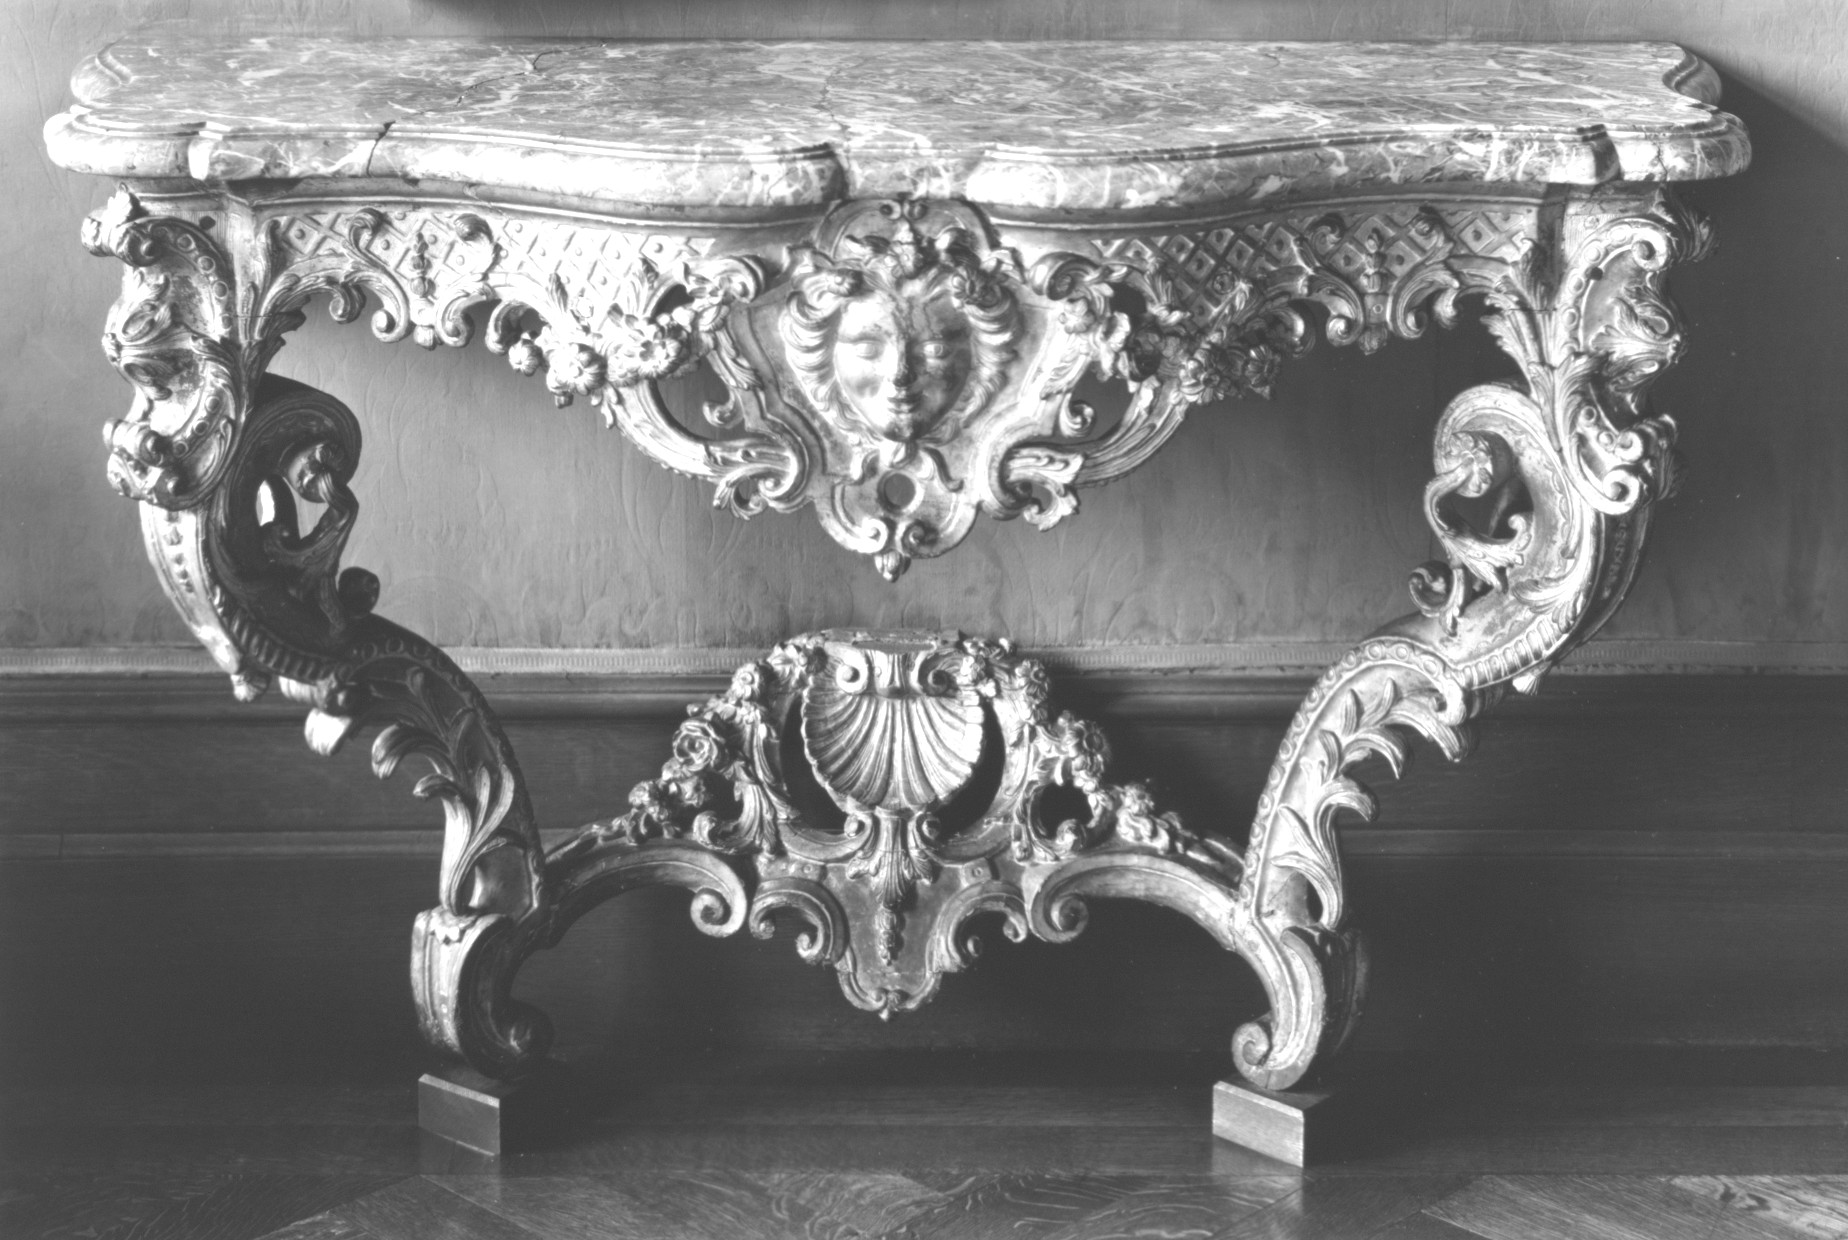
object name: console table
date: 1701-1800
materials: marble, wood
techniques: carving, gilding